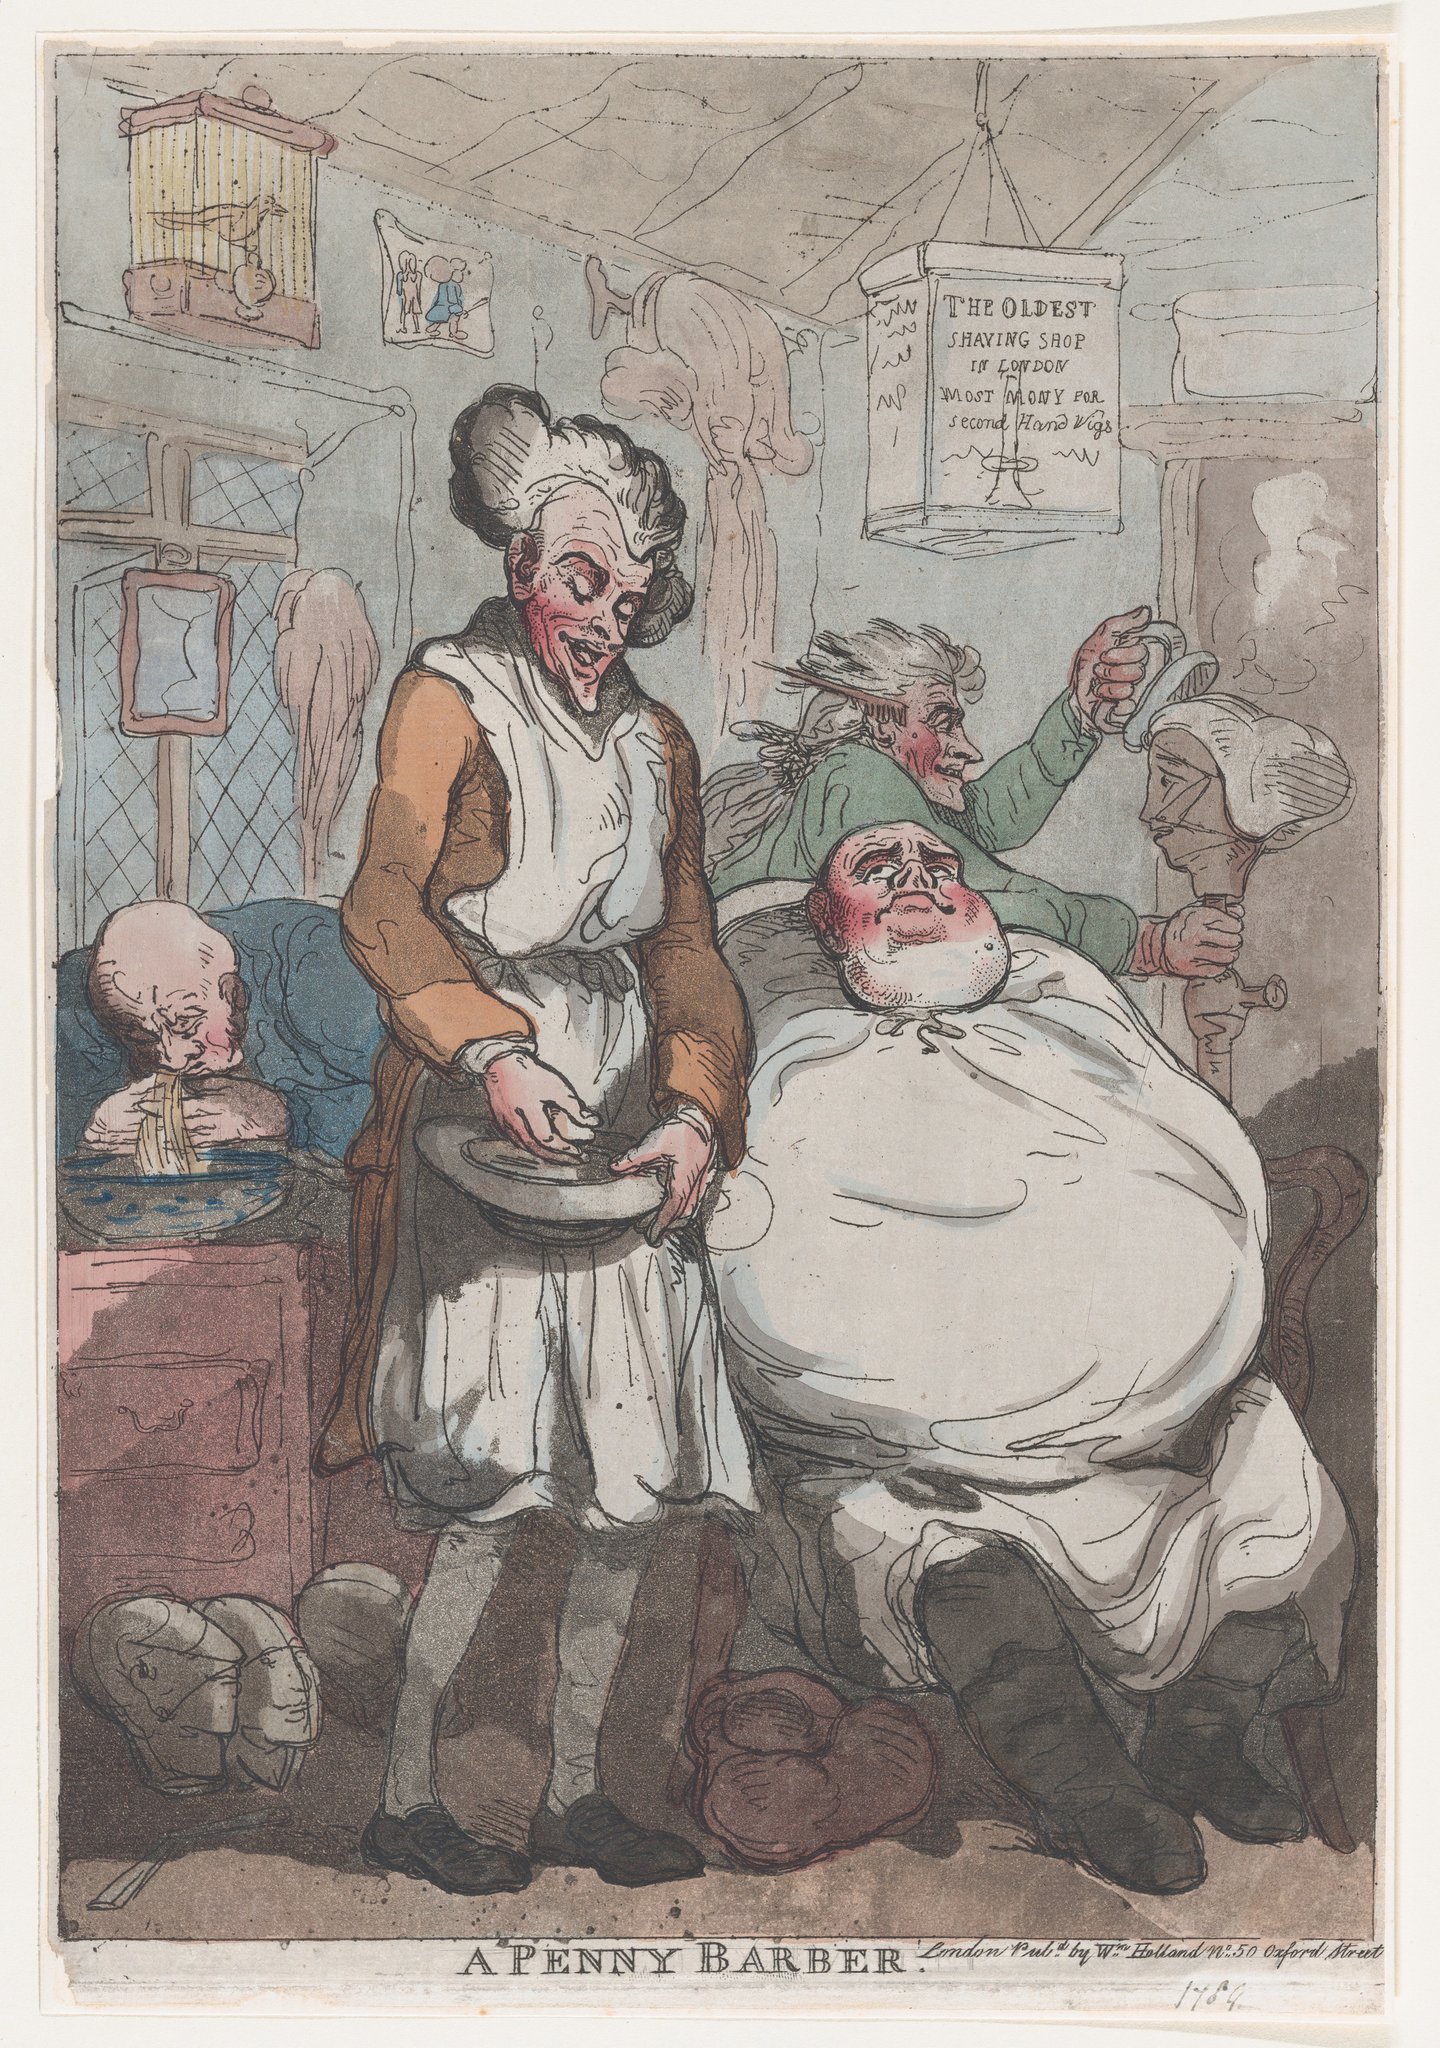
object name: print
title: A Penny Barber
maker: thomas rowlandson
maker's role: artist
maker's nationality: british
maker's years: 1757-1827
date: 1789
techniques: aquatint, etching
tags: satire,men,wigs,barbers